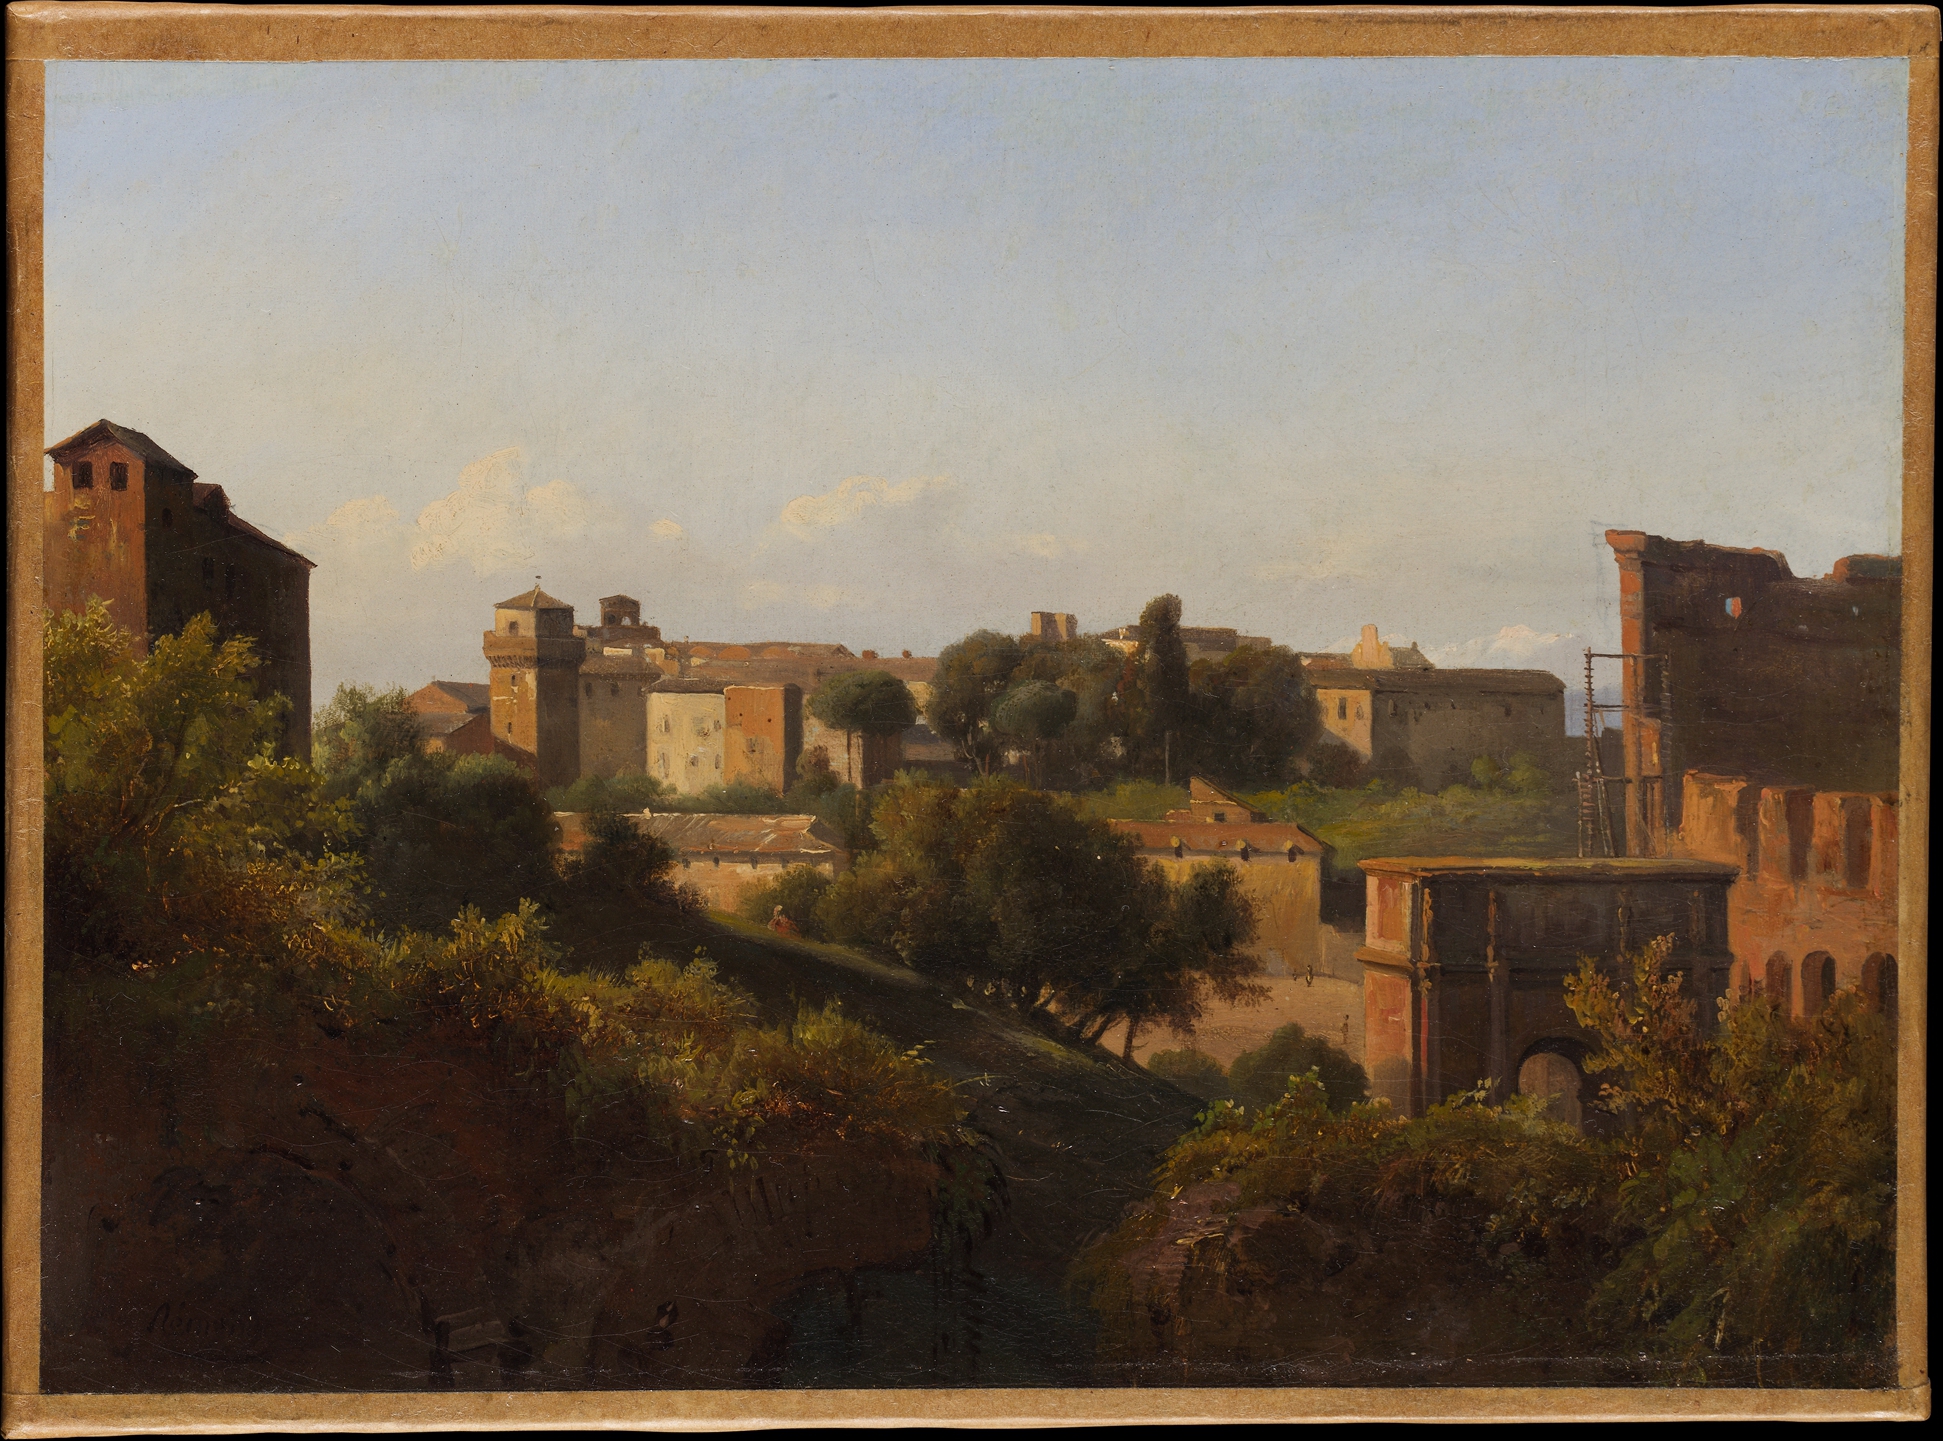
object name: painting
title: View of the Colosseum and the Arch of Constantine from the Palatine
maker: charles rémond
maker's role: artist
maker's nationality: french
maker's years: 1795-1875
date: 1822-1824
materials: canvas, oil, paper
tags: cities,ruins,rome